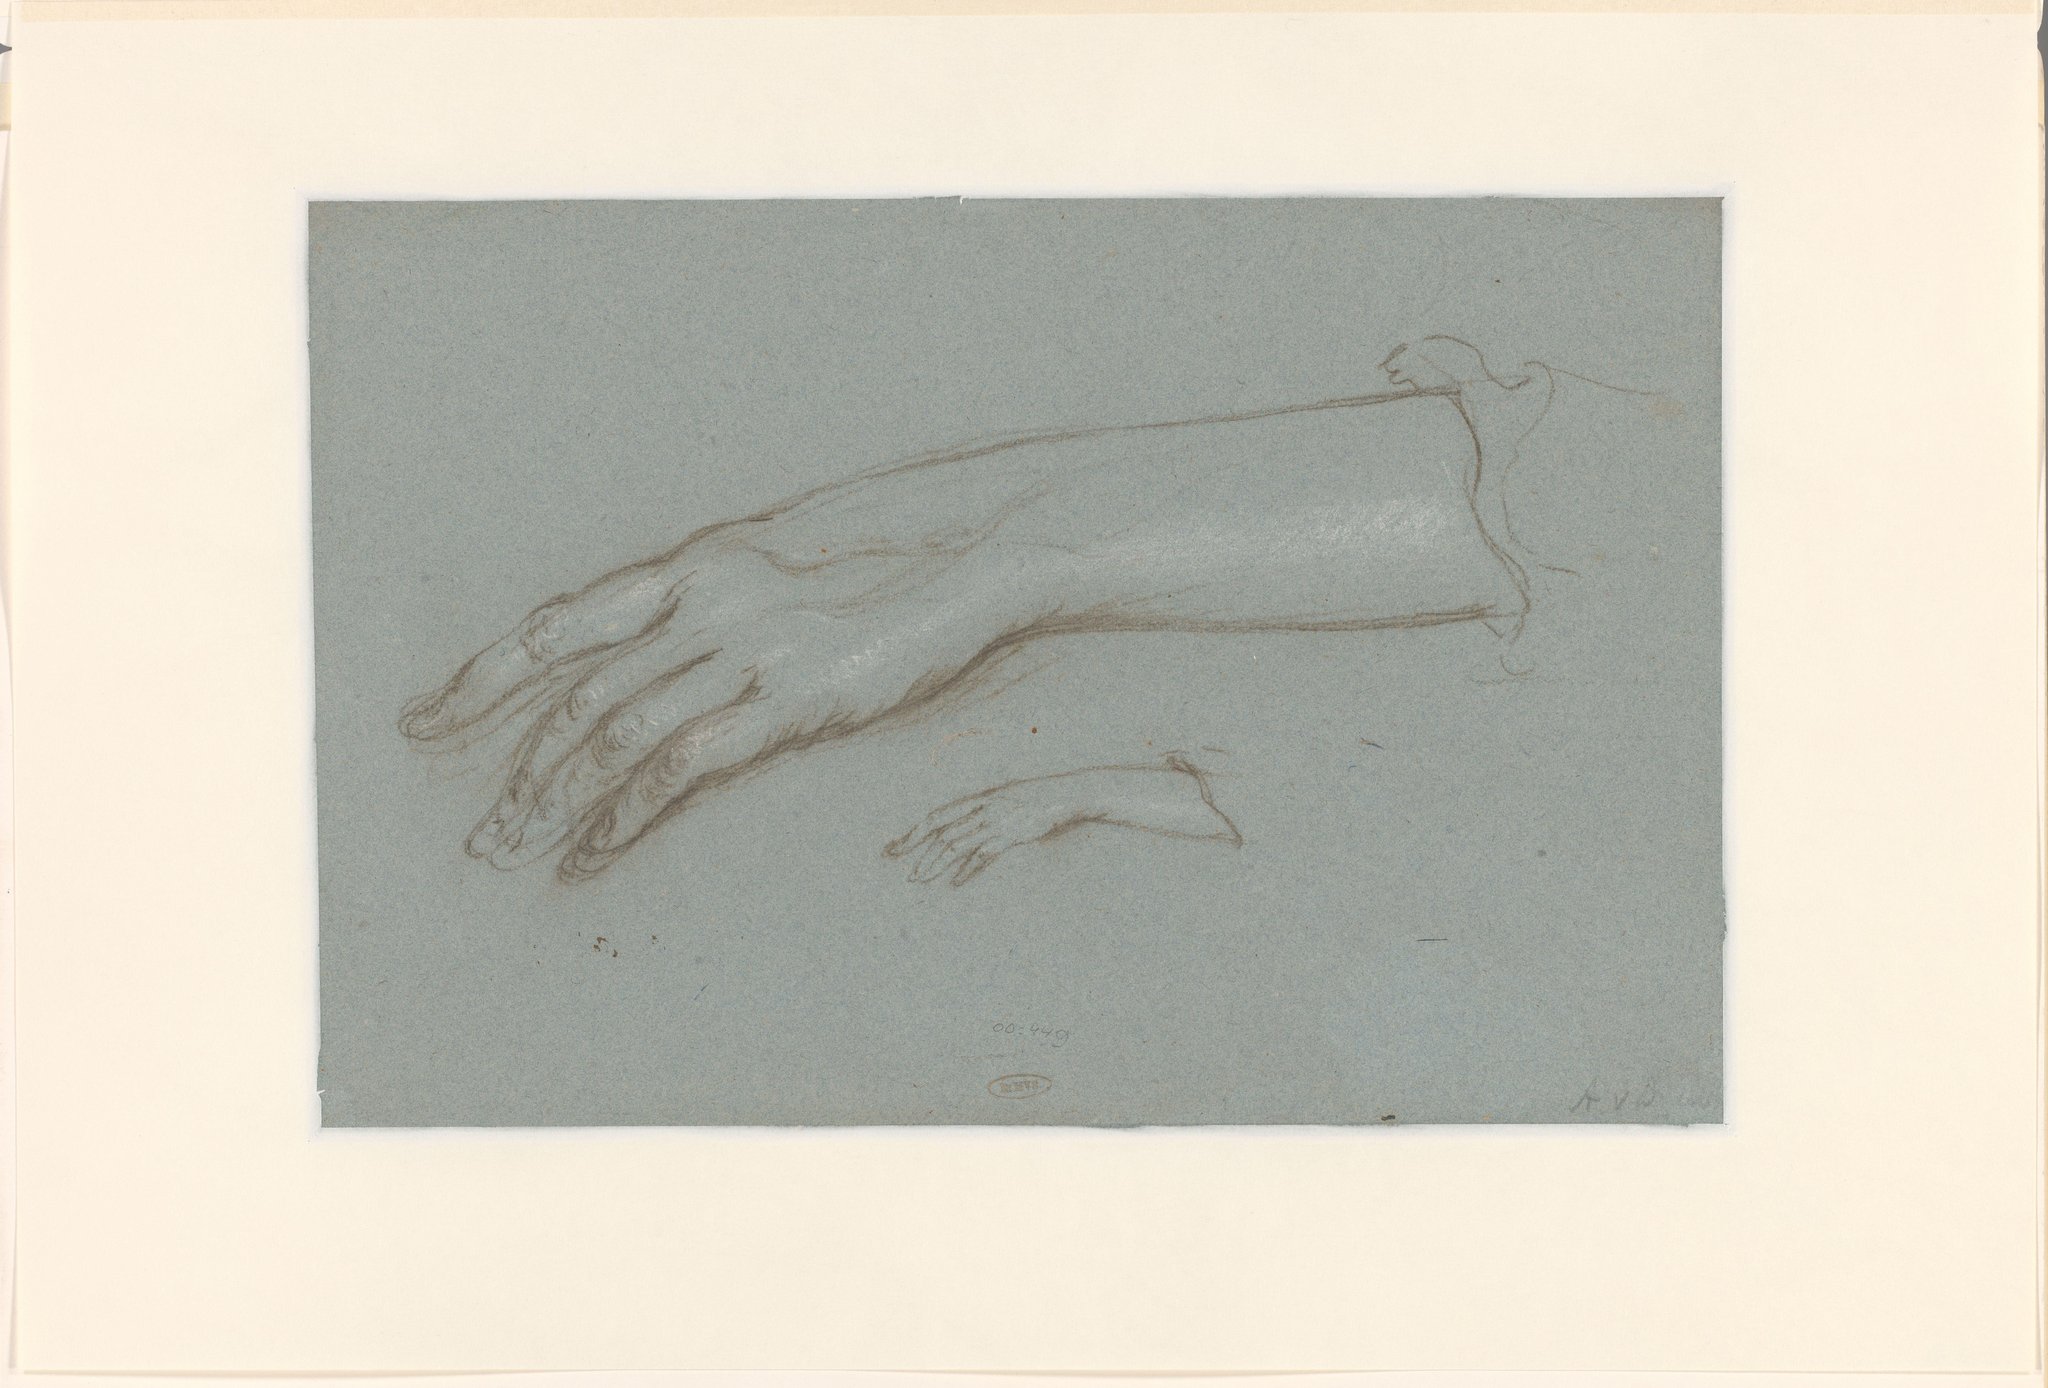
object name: drawing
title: Een grote en een kleine studie van een hand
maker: anthony van dyck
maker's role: draughtsman, painter, print maker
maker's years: 1599-1641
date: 1610-1641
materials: chalk, paper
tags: hand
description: Afkomstig uit een tekeningenalbum met onder andere figuur- en handstudies van of naar Caspar en Constantijn Netscher (BI-1894-3720). Tekening bevond zich oorspronkelijk op f. 28.